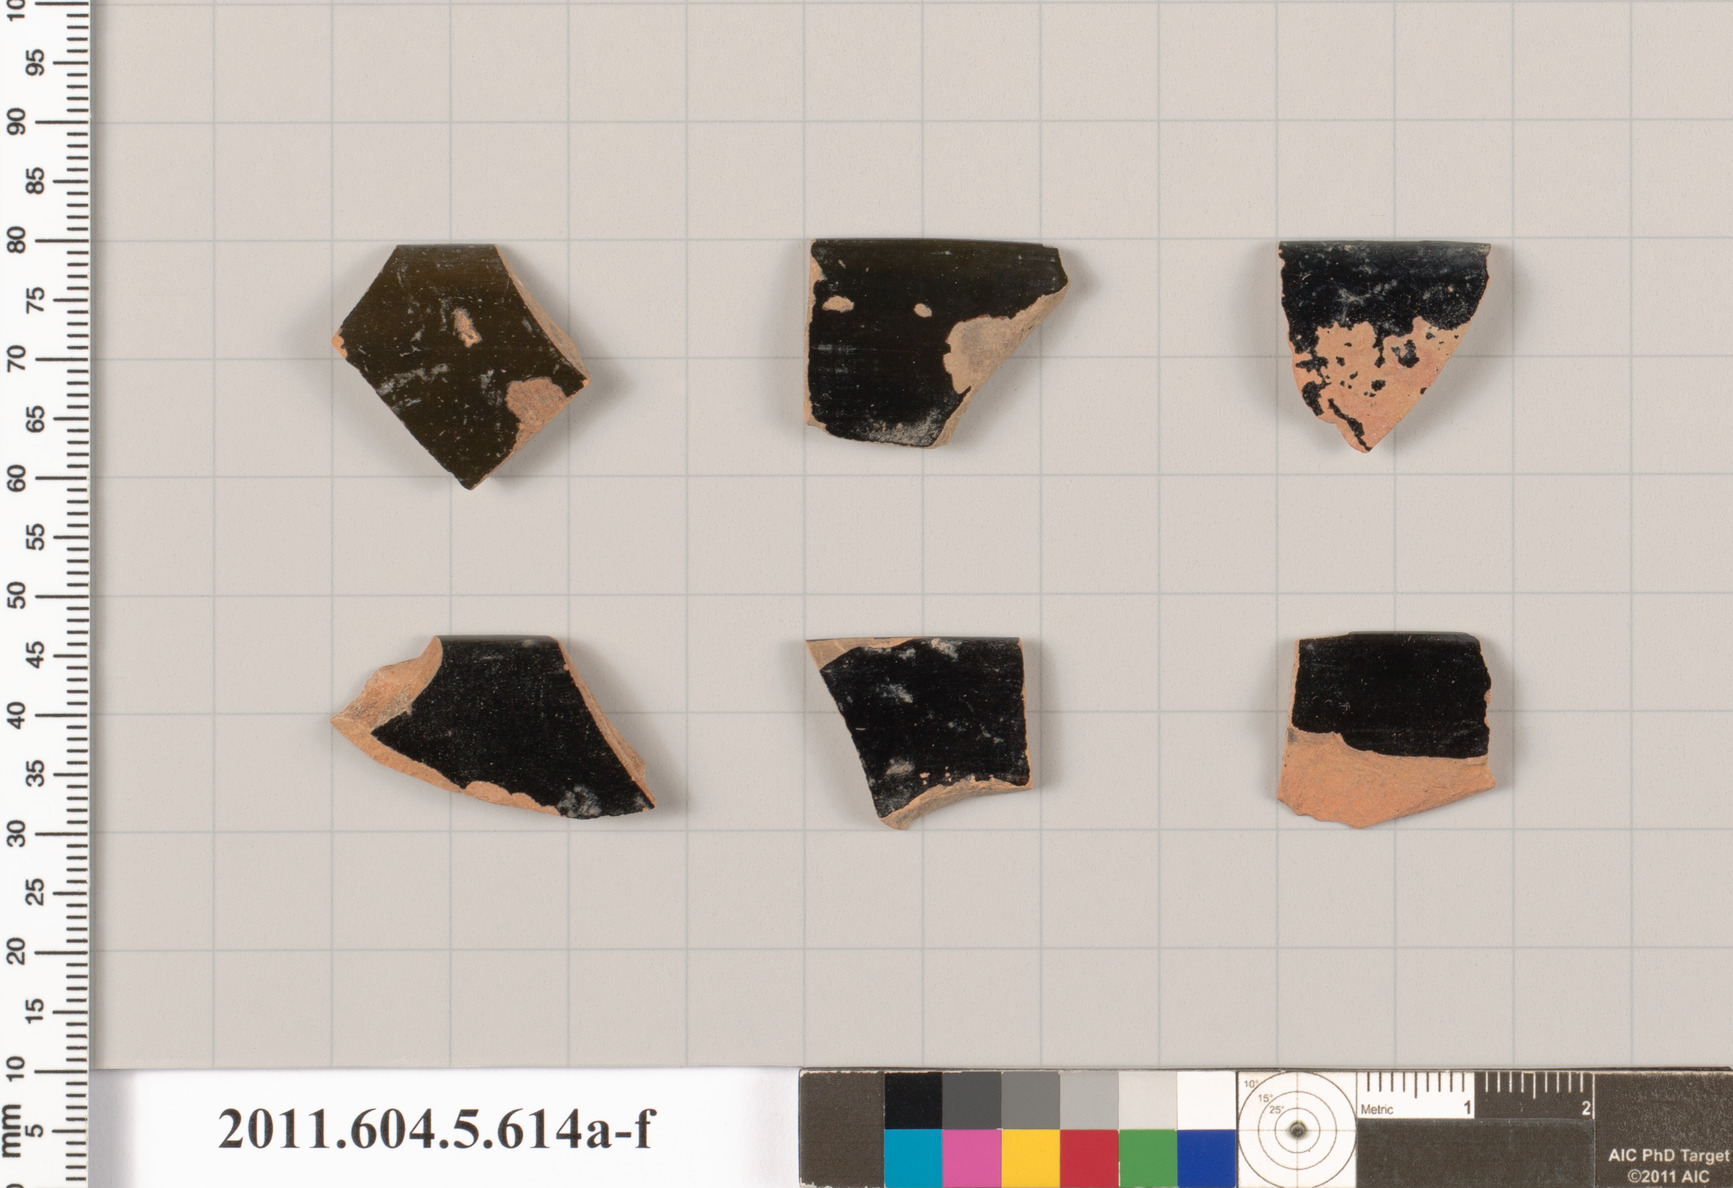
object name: kylix fragment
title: Terracotta rim fragments of kylikes (drinking cups)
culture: greek, attic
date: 600-401 BCE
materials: terracotta